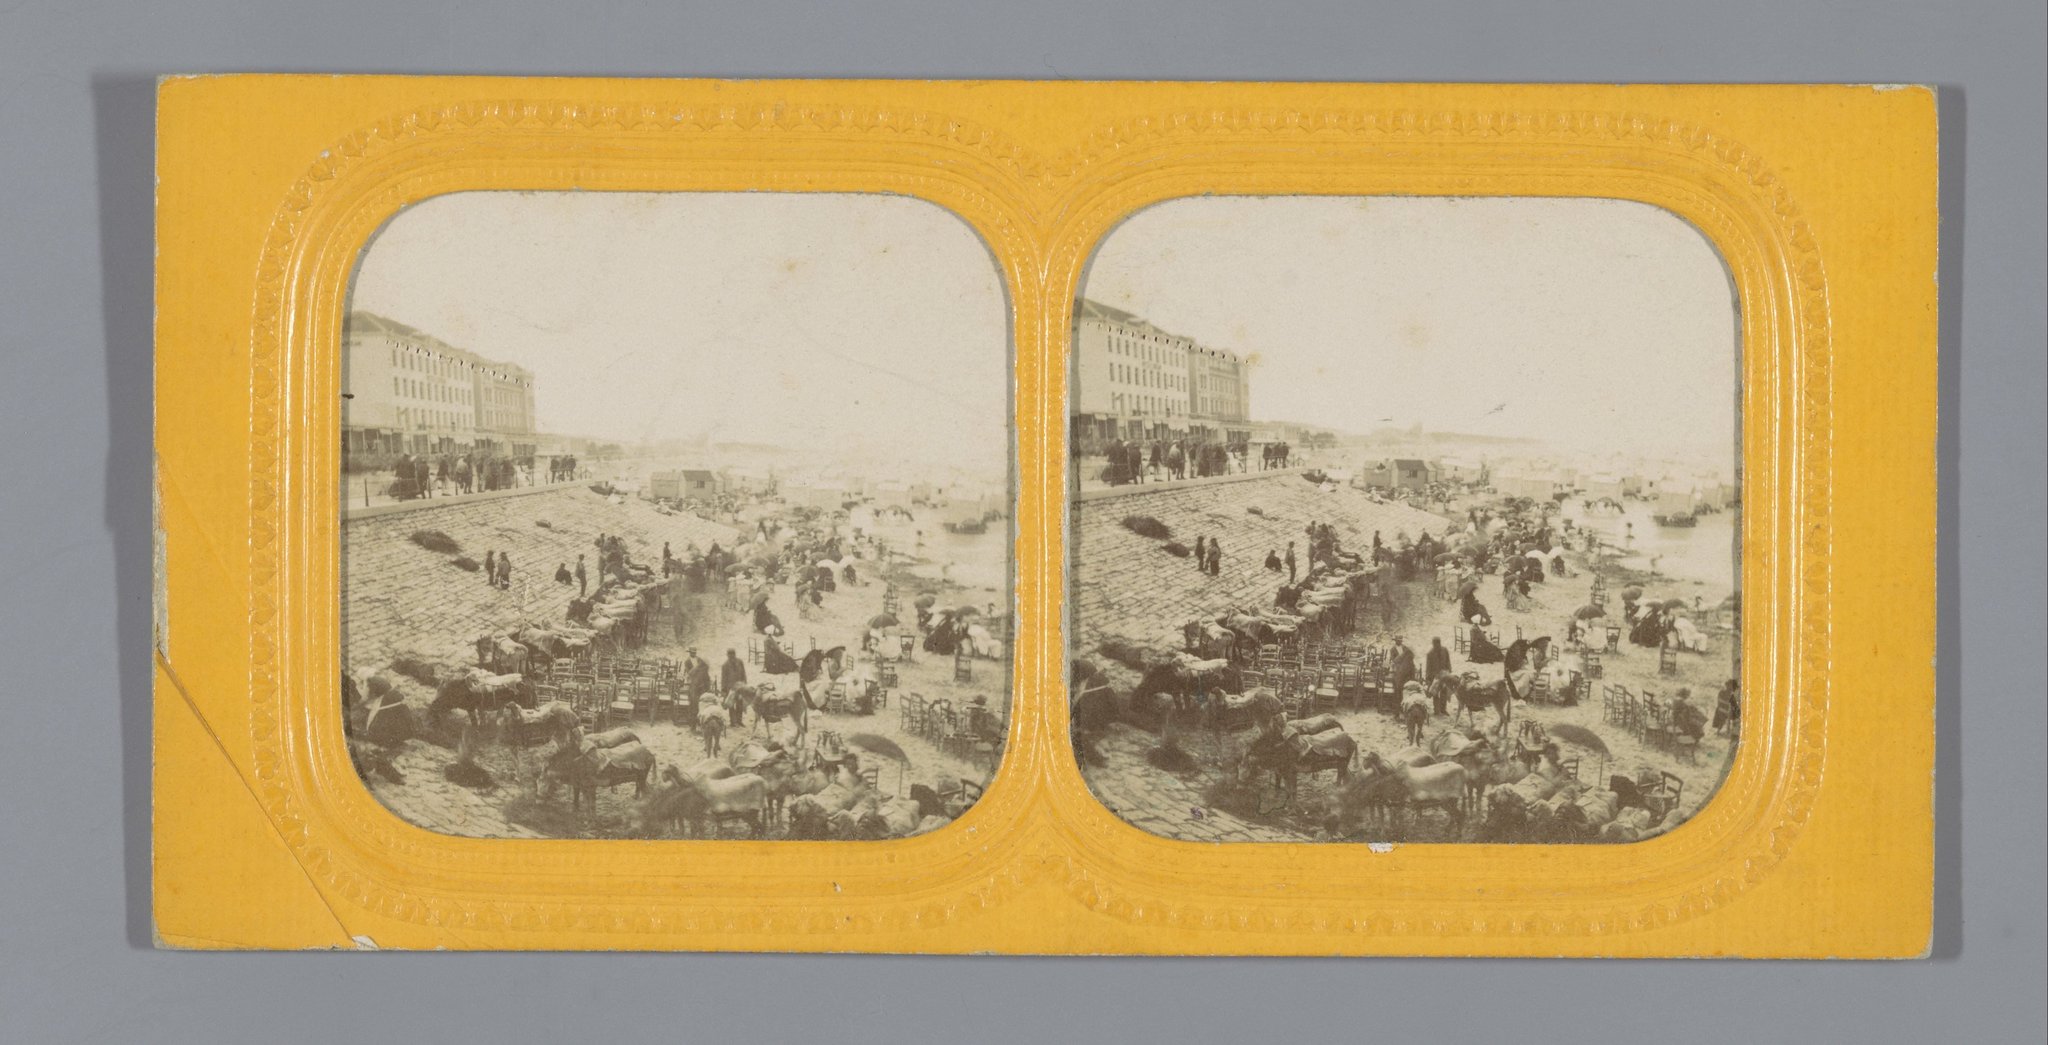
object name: tissue stereograph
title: Ostende la Plage, Belgique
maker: Anonymous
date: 1865-1875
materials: cardboard, paper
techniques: albumen print, hand coloring, perforating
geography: oostende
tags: beach (as place of recreation), two-wheeled vehicle drawn by one animal, donkey-riding (on the beach)